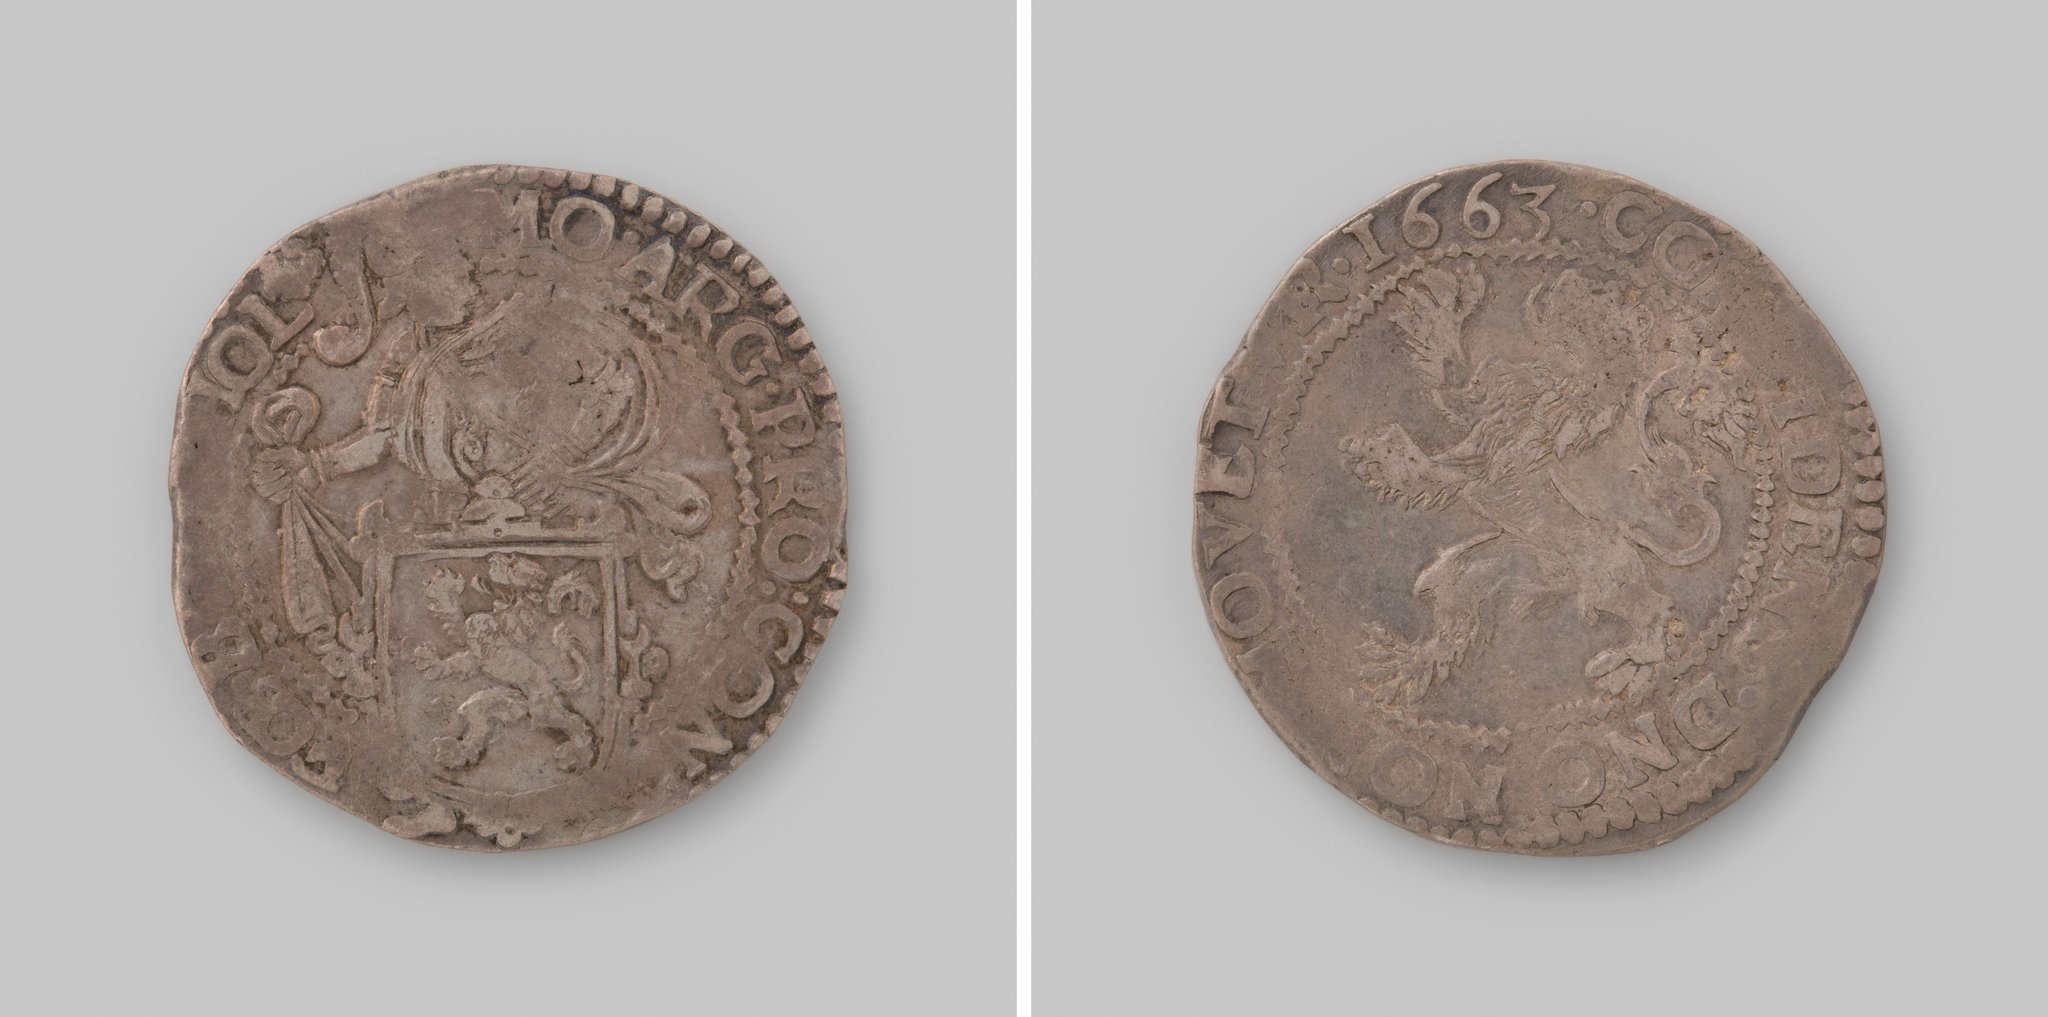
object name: coin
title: Holland, leeuwendaalder, 1663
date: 1663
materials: silver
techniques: striking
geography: dordrecht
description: Zilveren munt. Voorzijde: ridder met helm met pluim naar rechts kijkend met voor zich wapenschild van Holland. Keerzijde: klimmende leeuw naar links. In omschrift jaartal.